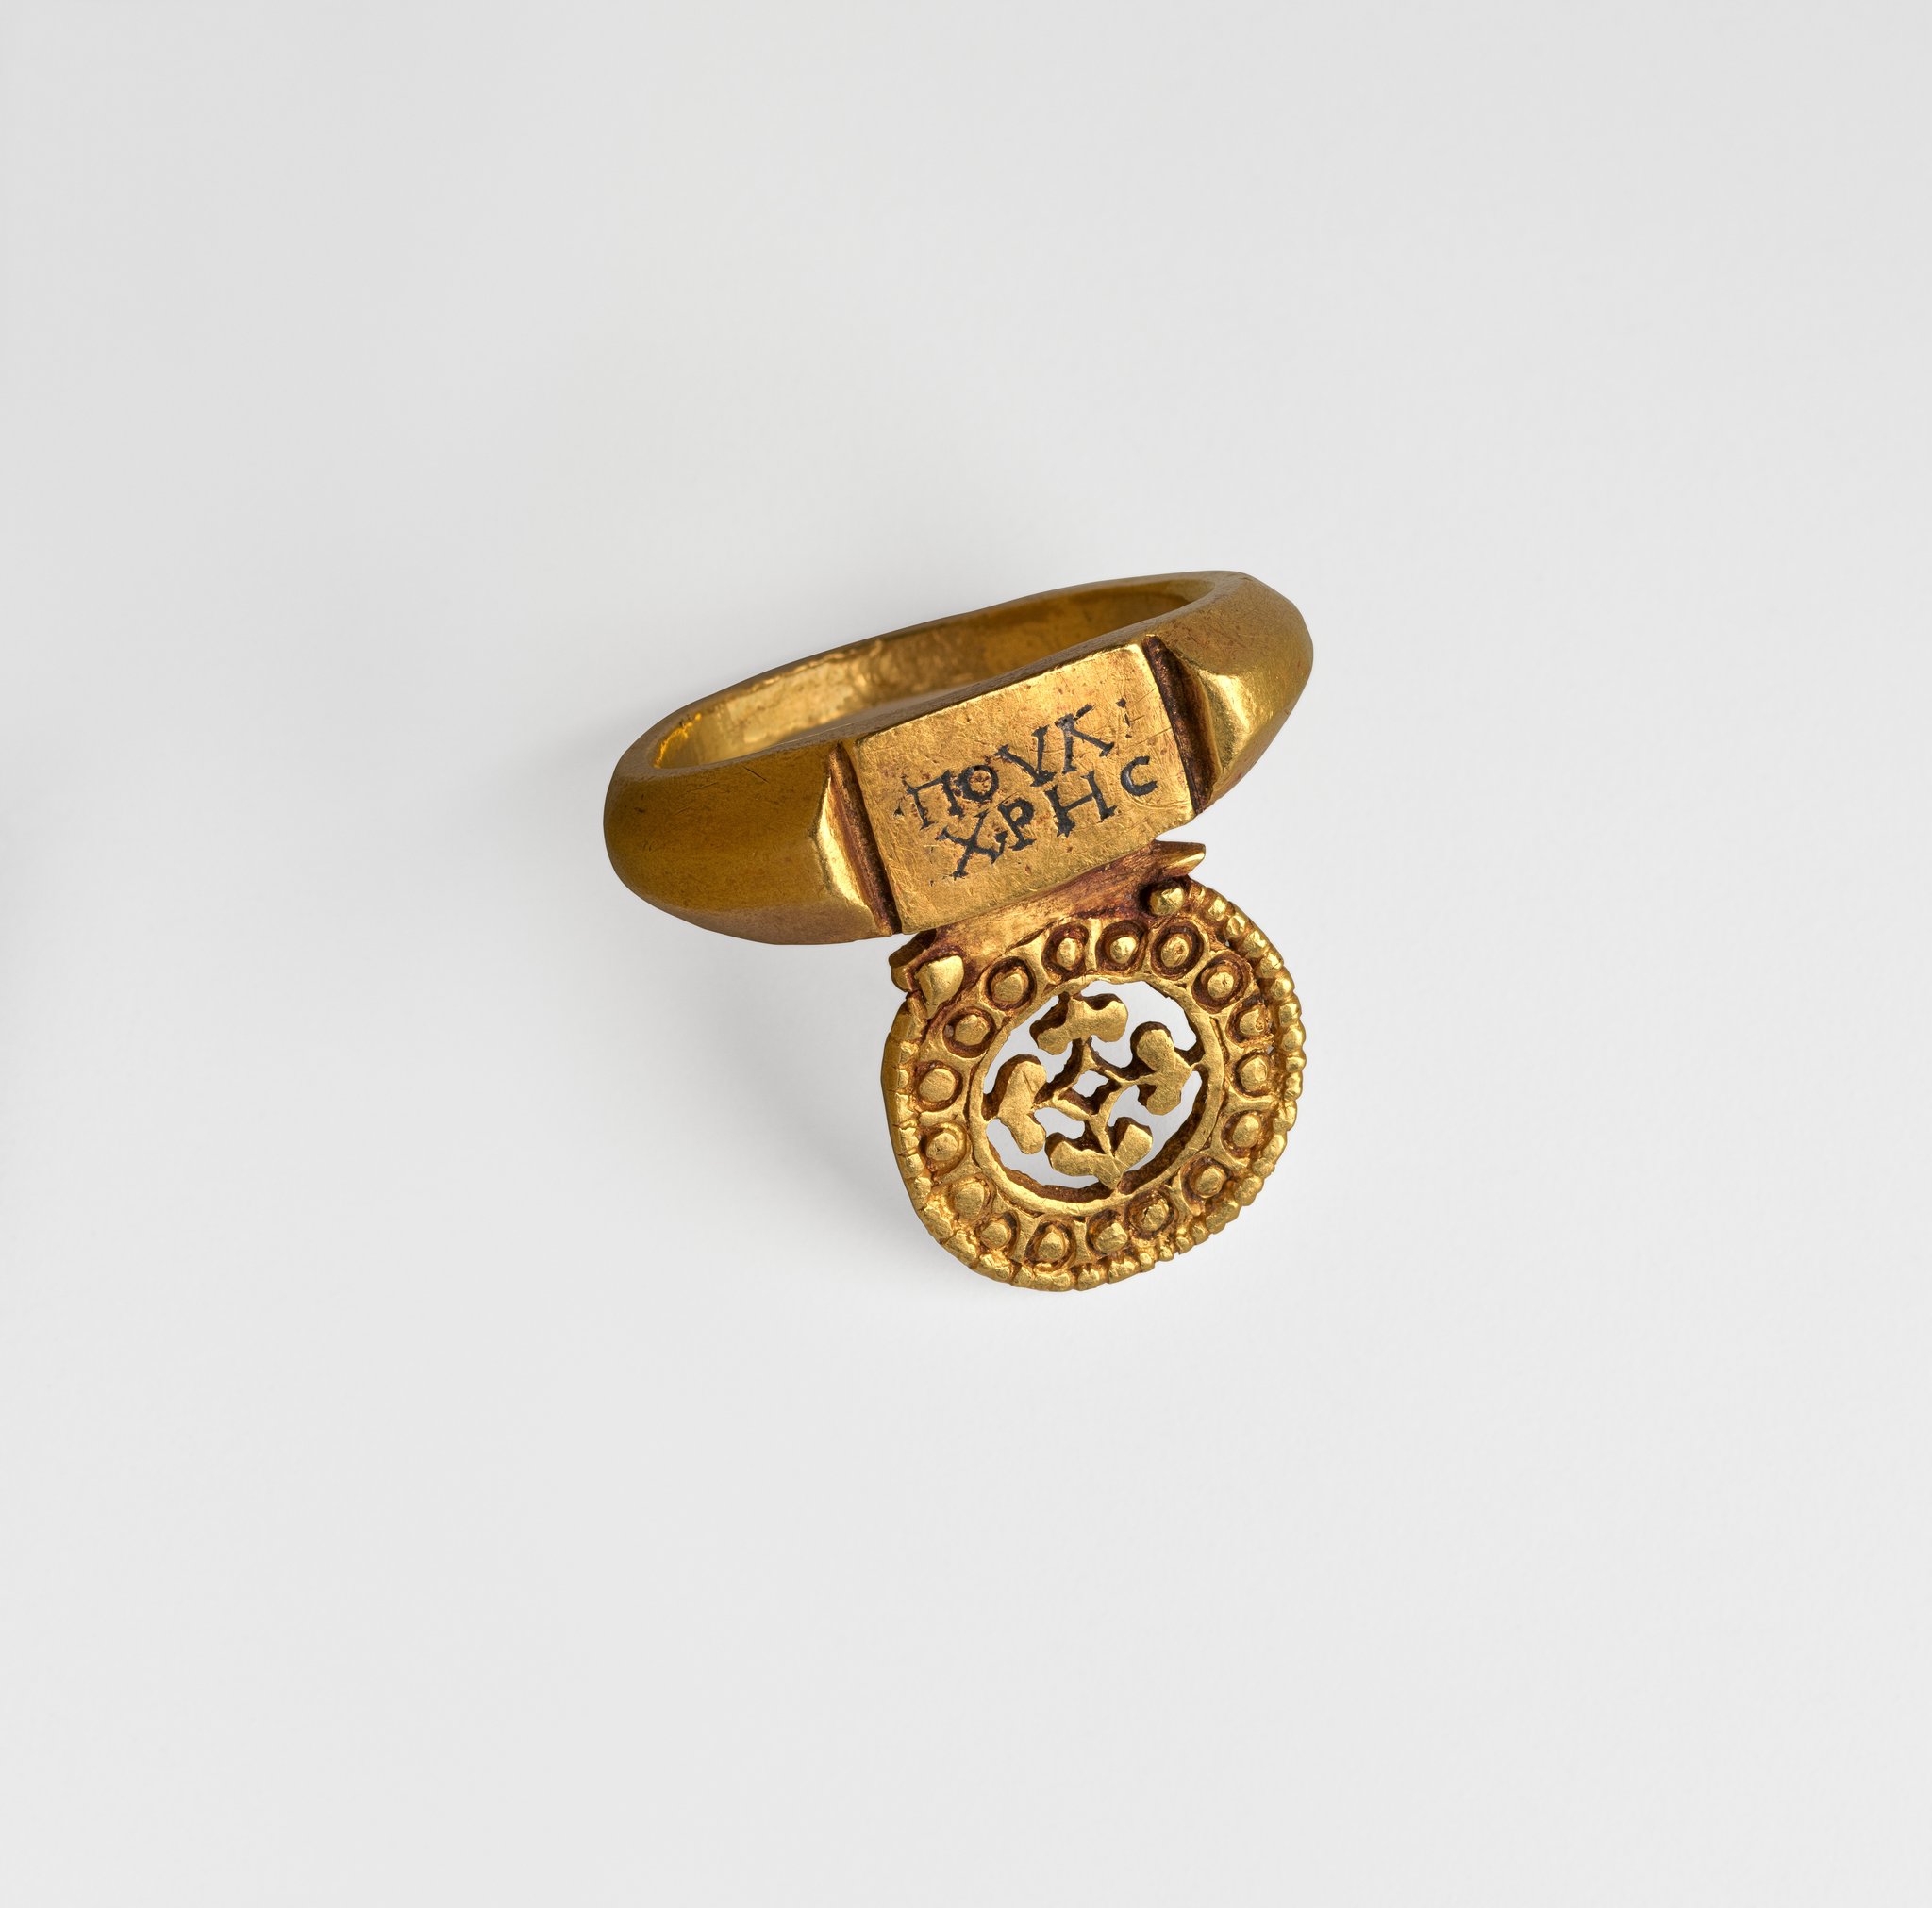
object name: ring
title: Roman Key Ring with Inscription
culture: byzantine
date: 301-400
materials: gold